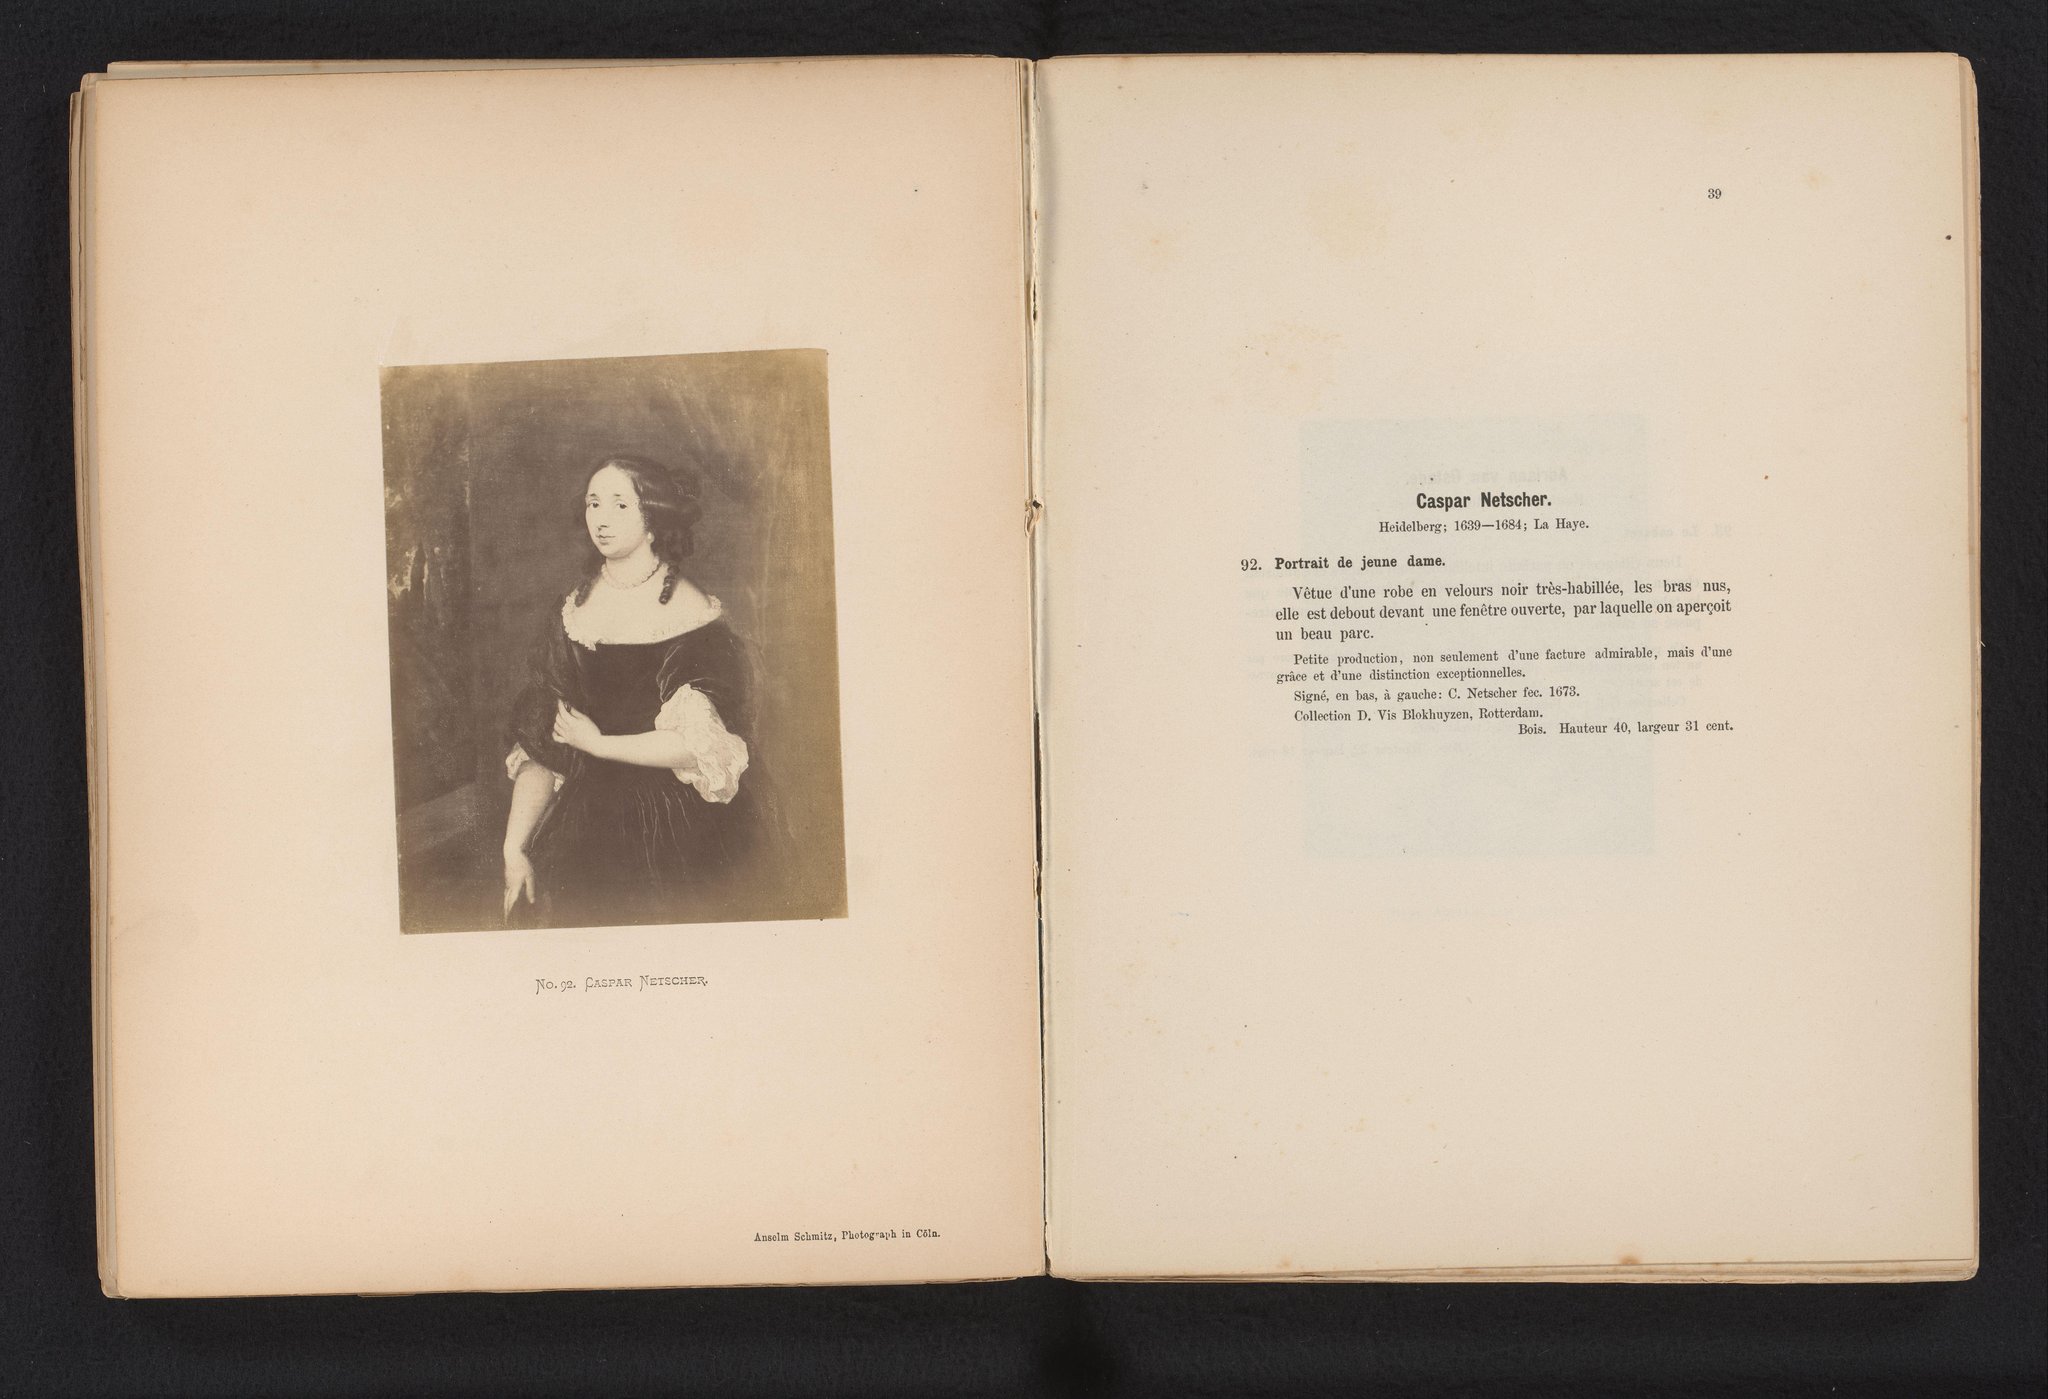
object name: page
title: Fotoreproductie van een portret van een onbekende vrouw door Caspar Netscher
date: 1871-1876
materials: photographic support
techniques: albumen print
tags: historical persons - bb - woman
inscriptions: inscription: ‘No. 92. Caspar Netscher’